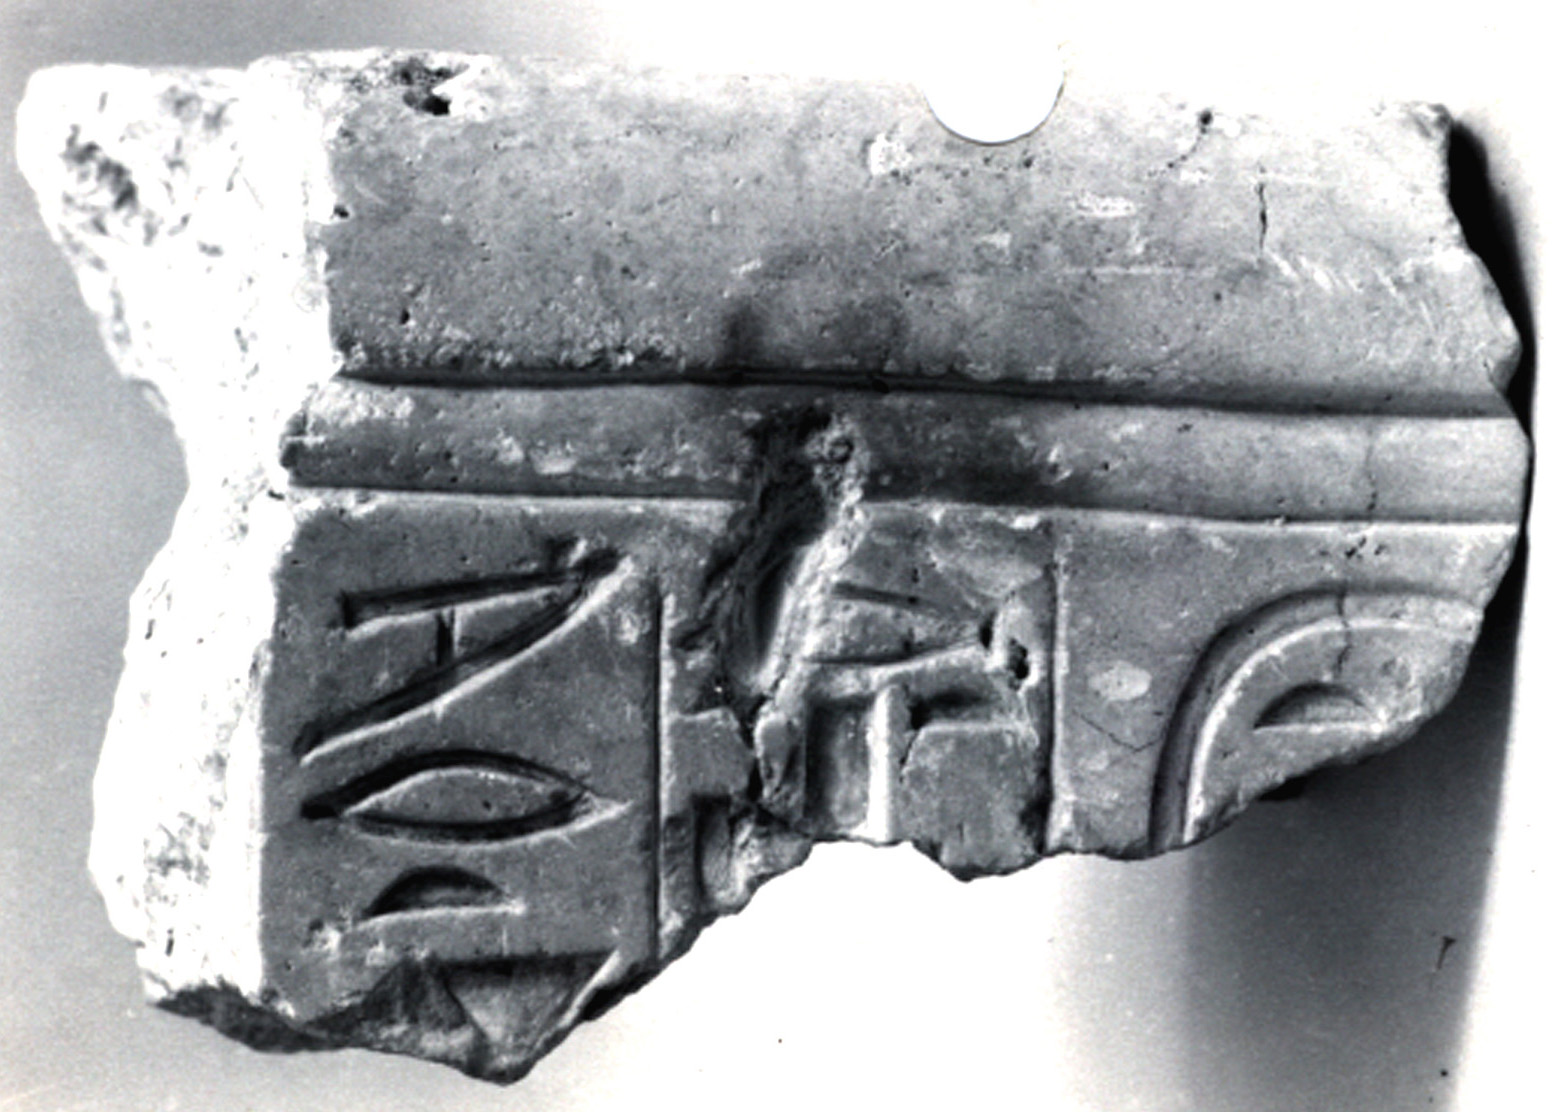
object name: balustrade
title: Balustrade fragment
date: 1353-1336 BCE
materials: limestone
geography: egypt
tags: hieroglyphs